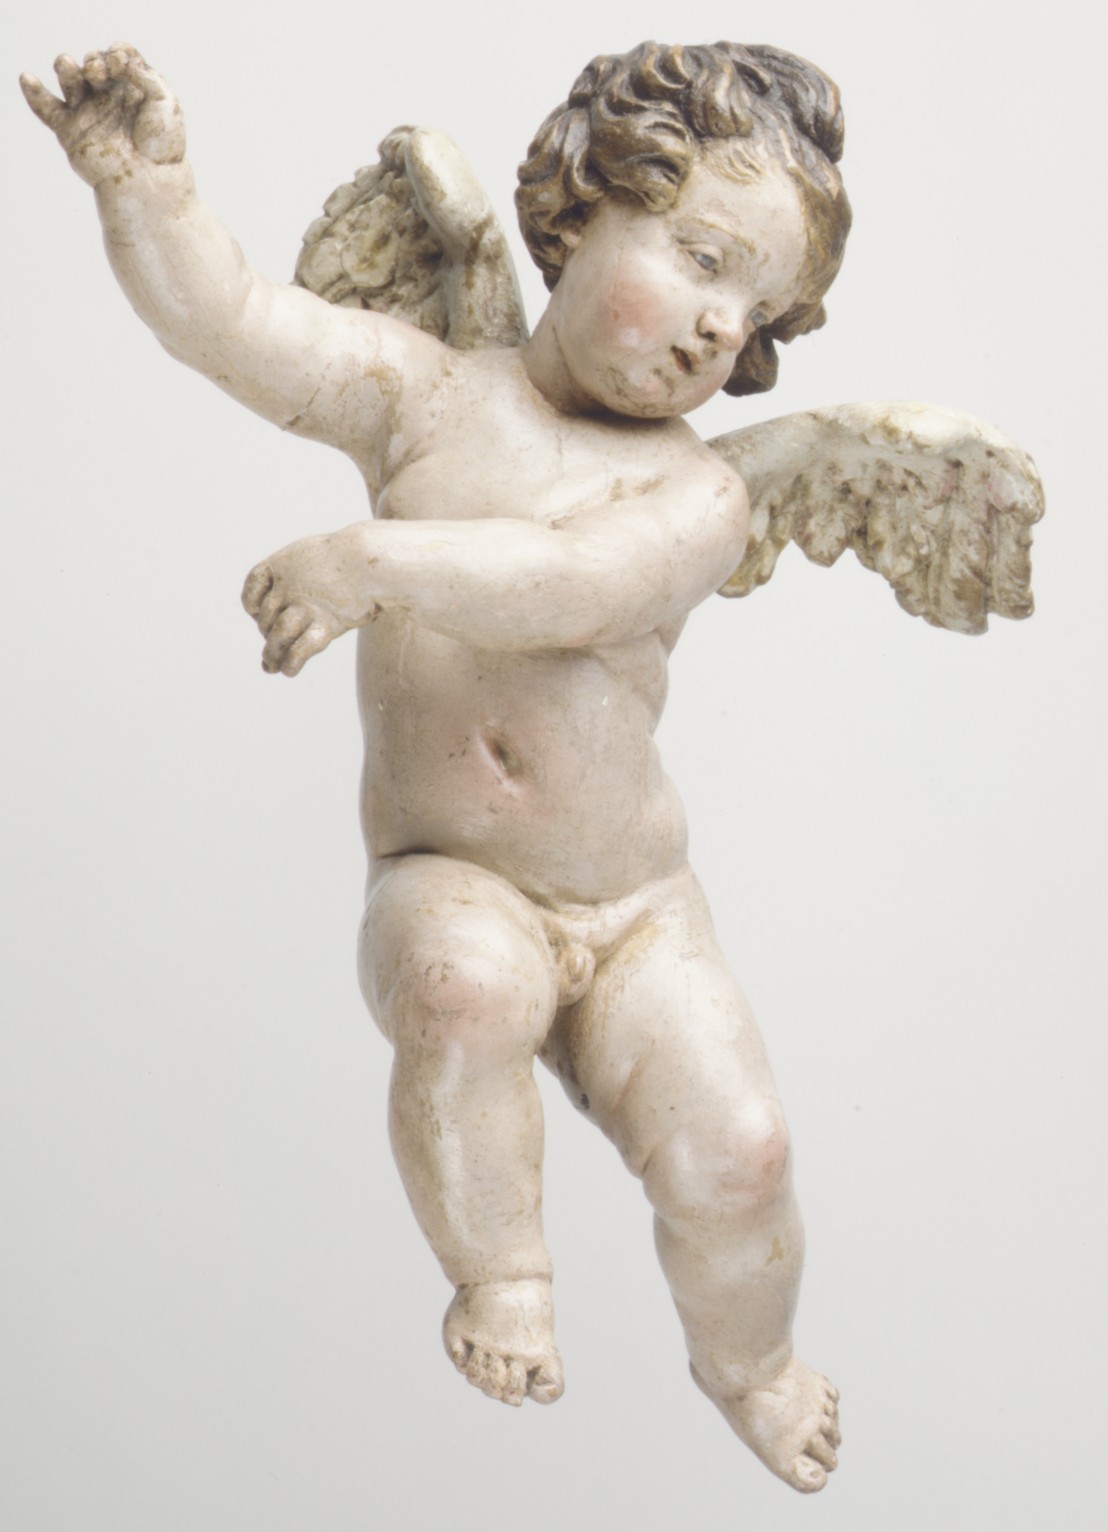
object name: crèche figure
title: Cherub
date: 1751-1800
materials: wood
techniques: polychrome